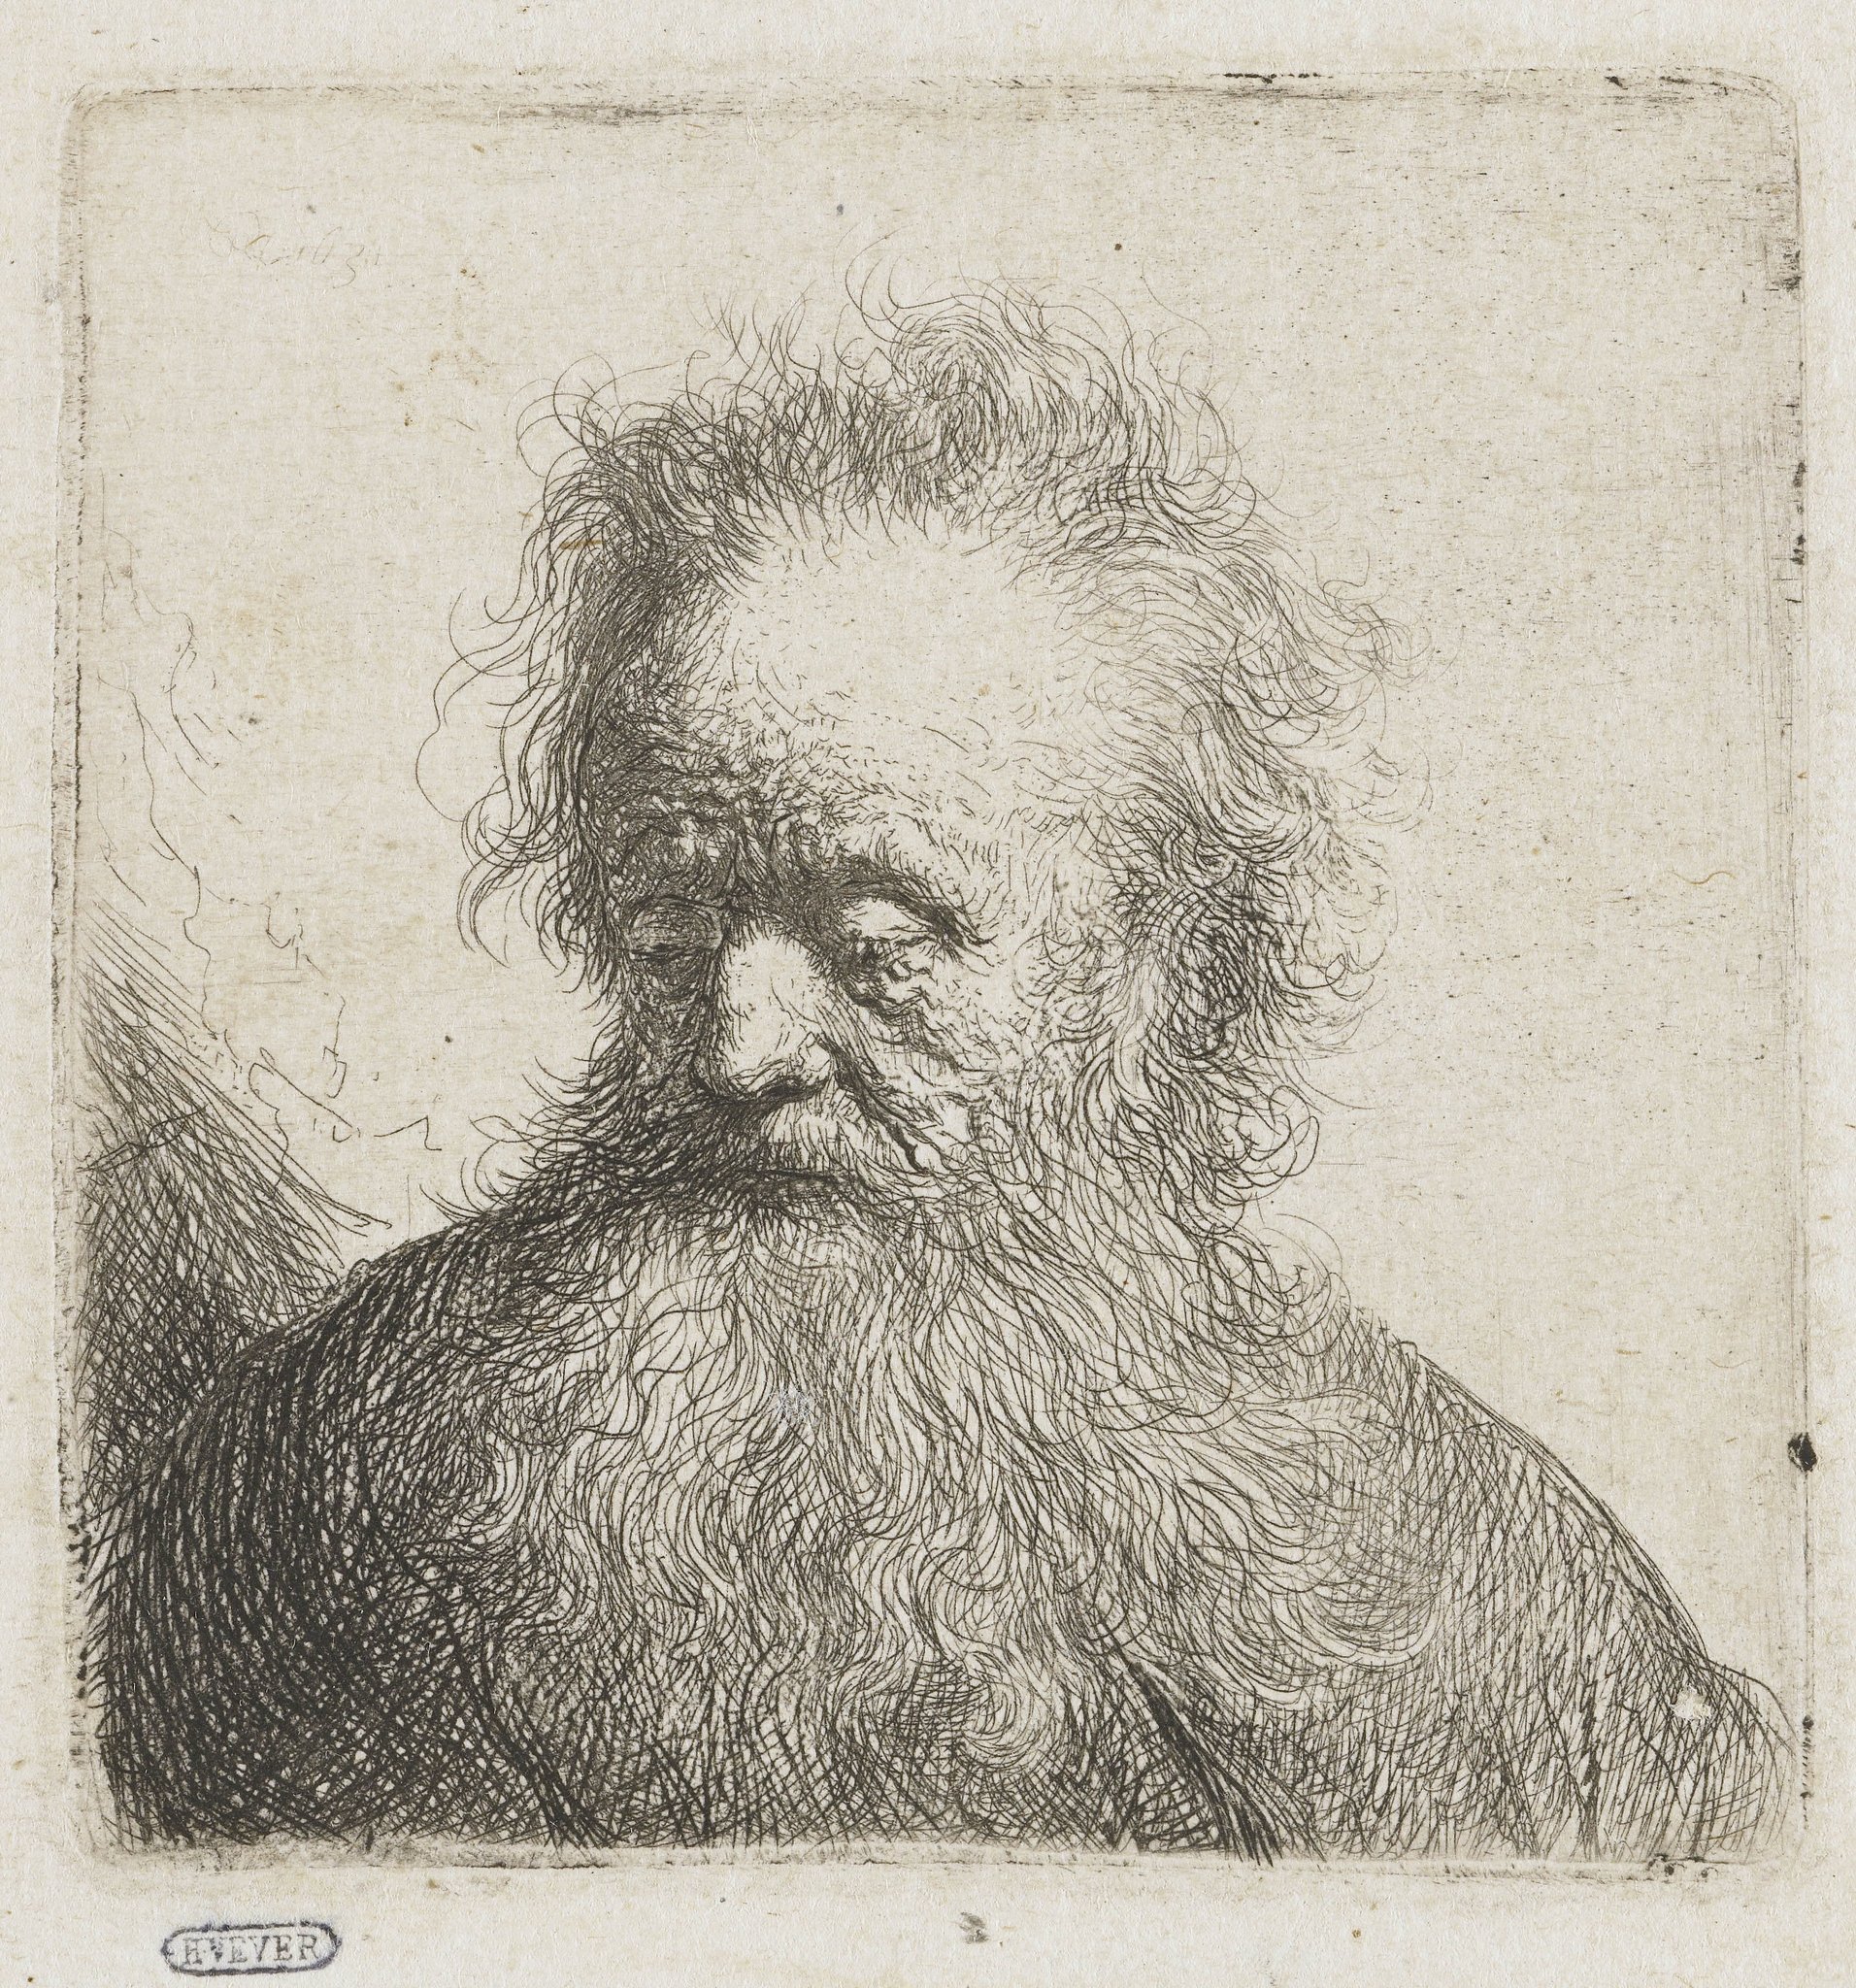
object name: print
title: Old Man with a Flowing Beard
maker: rembrandt van rijn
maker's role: draughtsman, painter, print maker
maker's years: 1606-1669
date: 1631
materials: paper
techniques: etching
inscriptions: monogram and date: ‘RHL 1631’, mark: Lugt 119, mark: Lugt 2491 bis, mark: Lugt 2228, mark: Lugt 2491 bis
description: In these prints, Rembrandt studies the characteristics of age, always portraying the same full-bearded man. While slight differences can certainly be discerned, Rembrandt’s penchant for depicting his models while they look down, their heads slightly bent, is striking. This pose lends the studies a melancholy air.